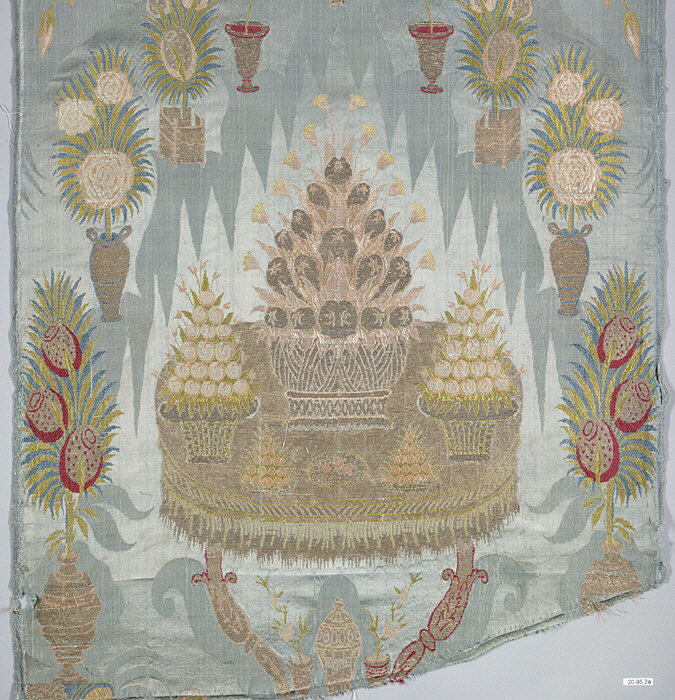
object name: piece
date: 1705-1715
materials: metal thread, silk